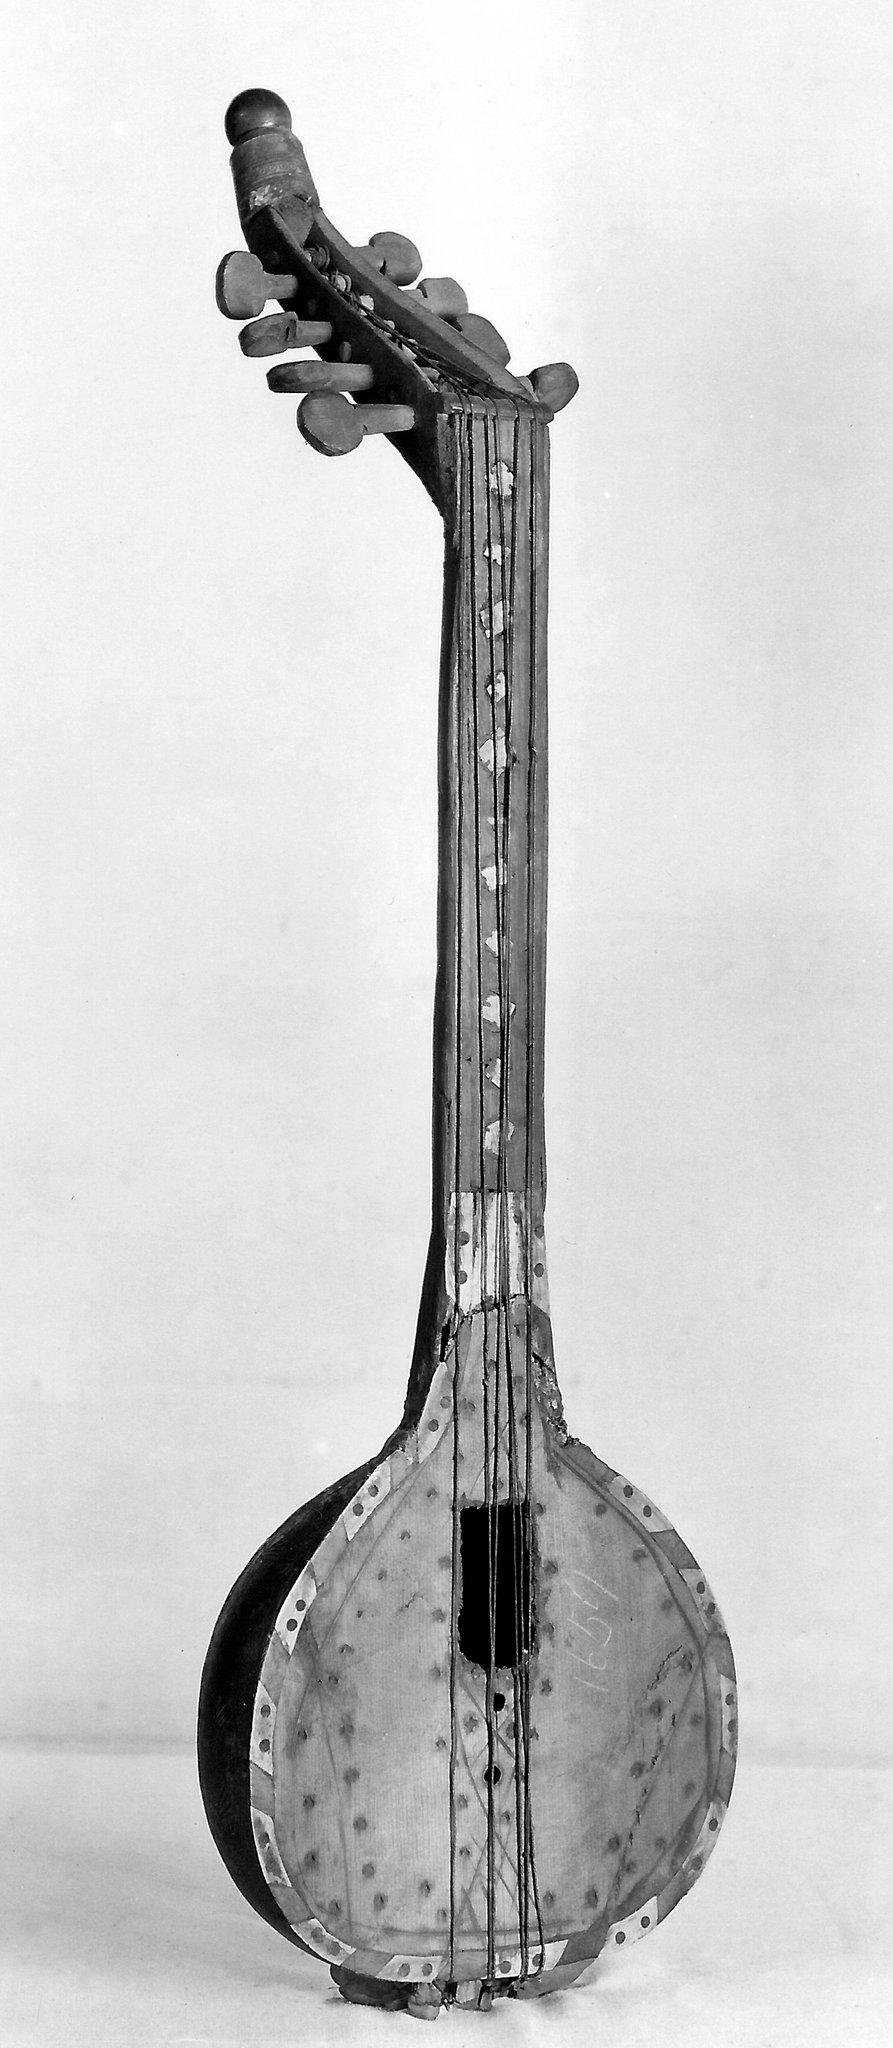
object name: quwaytara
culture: tanzanian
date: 1867-1900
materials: ivory, wood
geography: tanzania